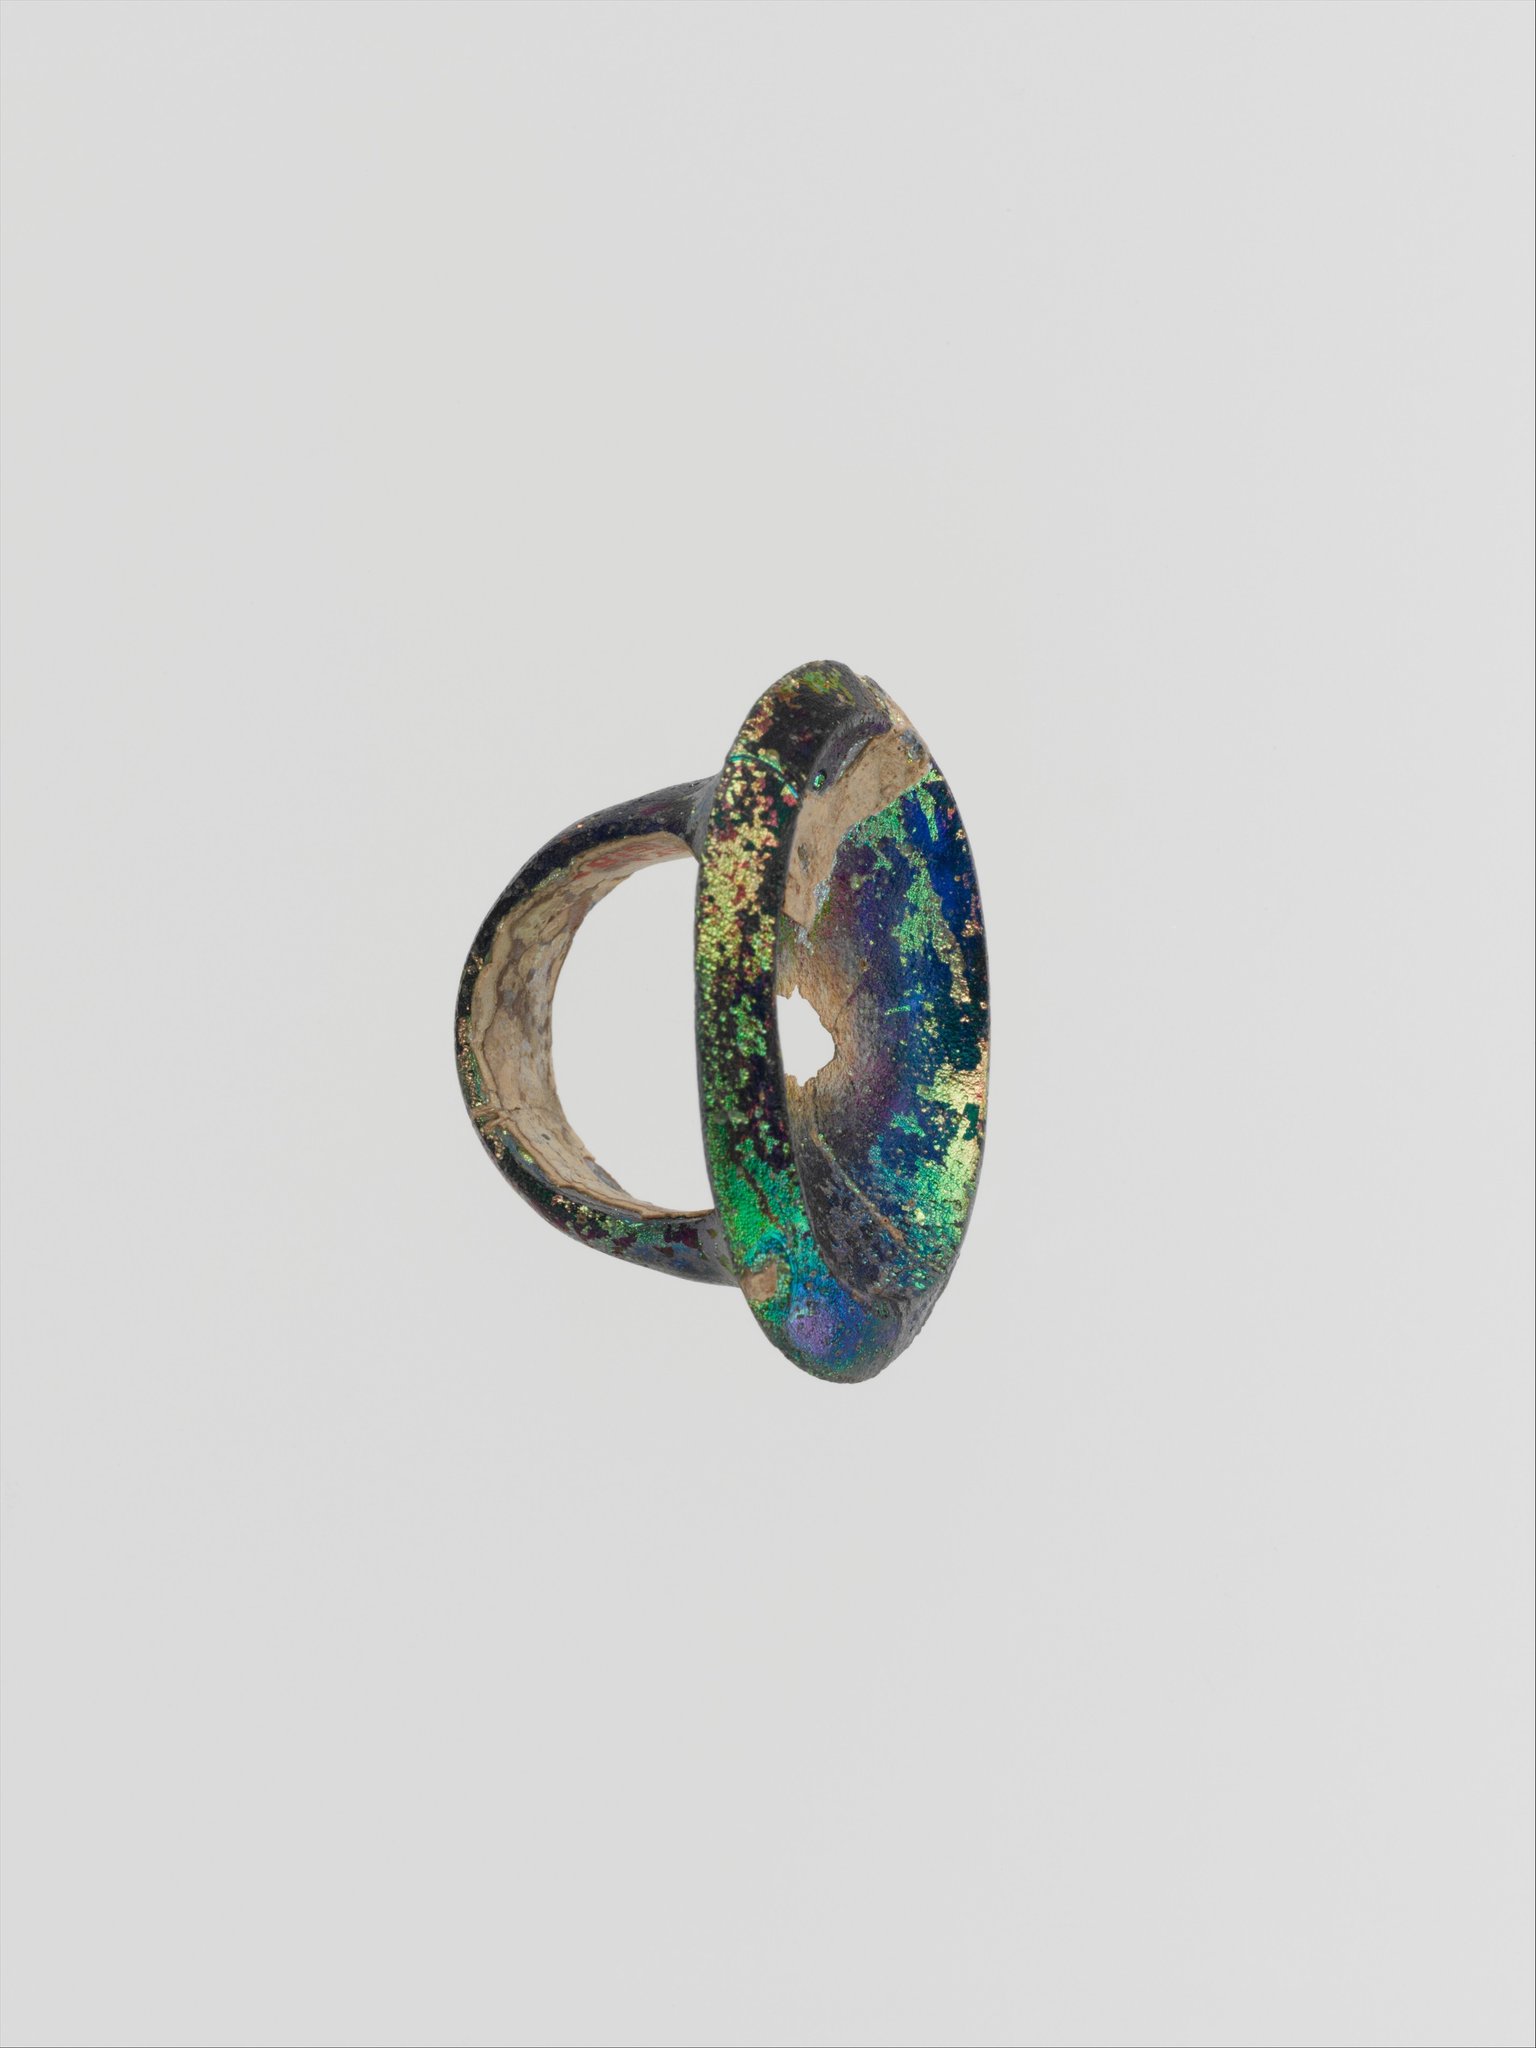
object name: ring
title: Glass finger ring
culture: greek, eastern mediterranean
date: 300-101 BCE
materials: glass